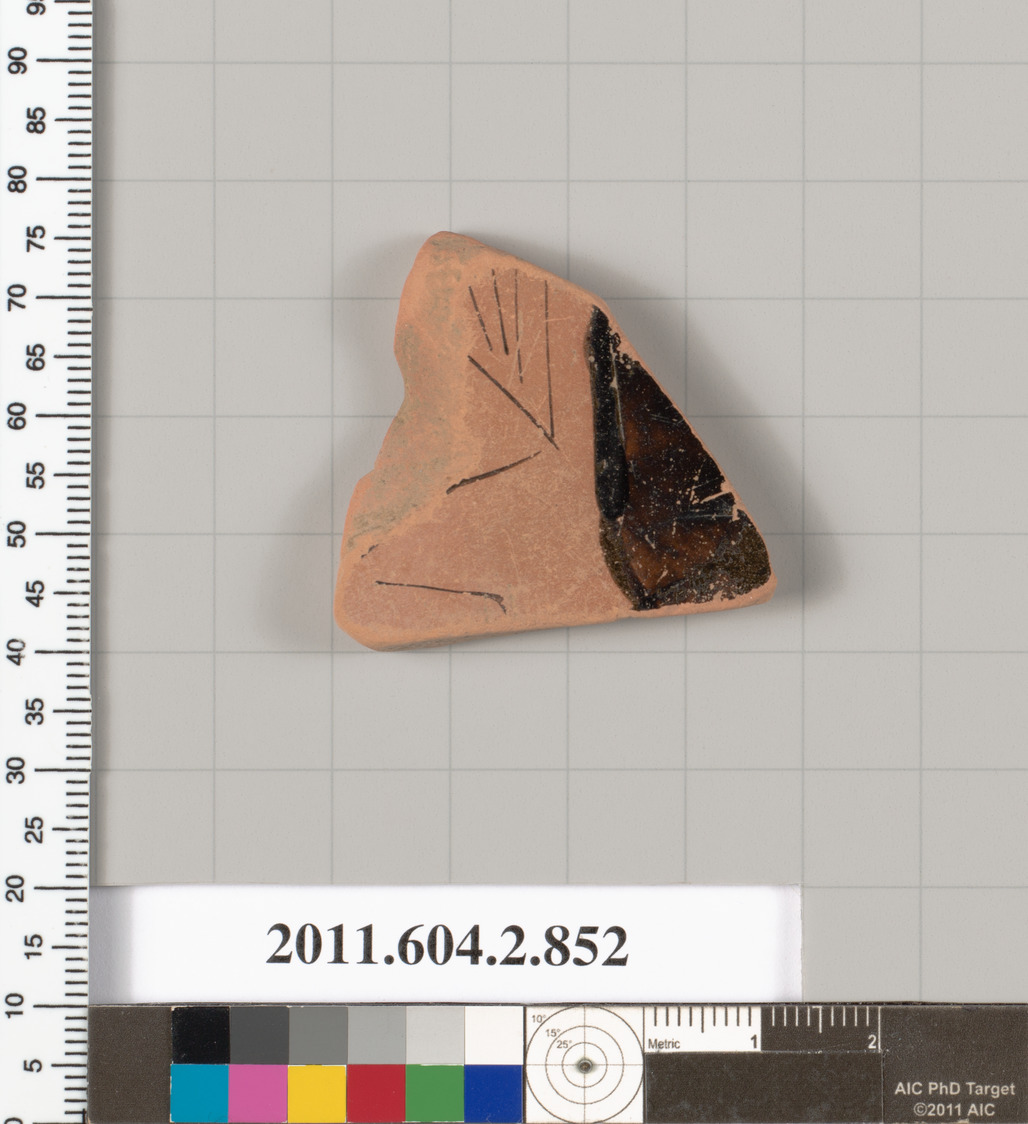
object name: bell krater fragment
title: Terracotta fragment of a bell-krater (bowl for mixing wine and water)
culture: greek, attic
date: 425-401 BCE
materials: terracotta